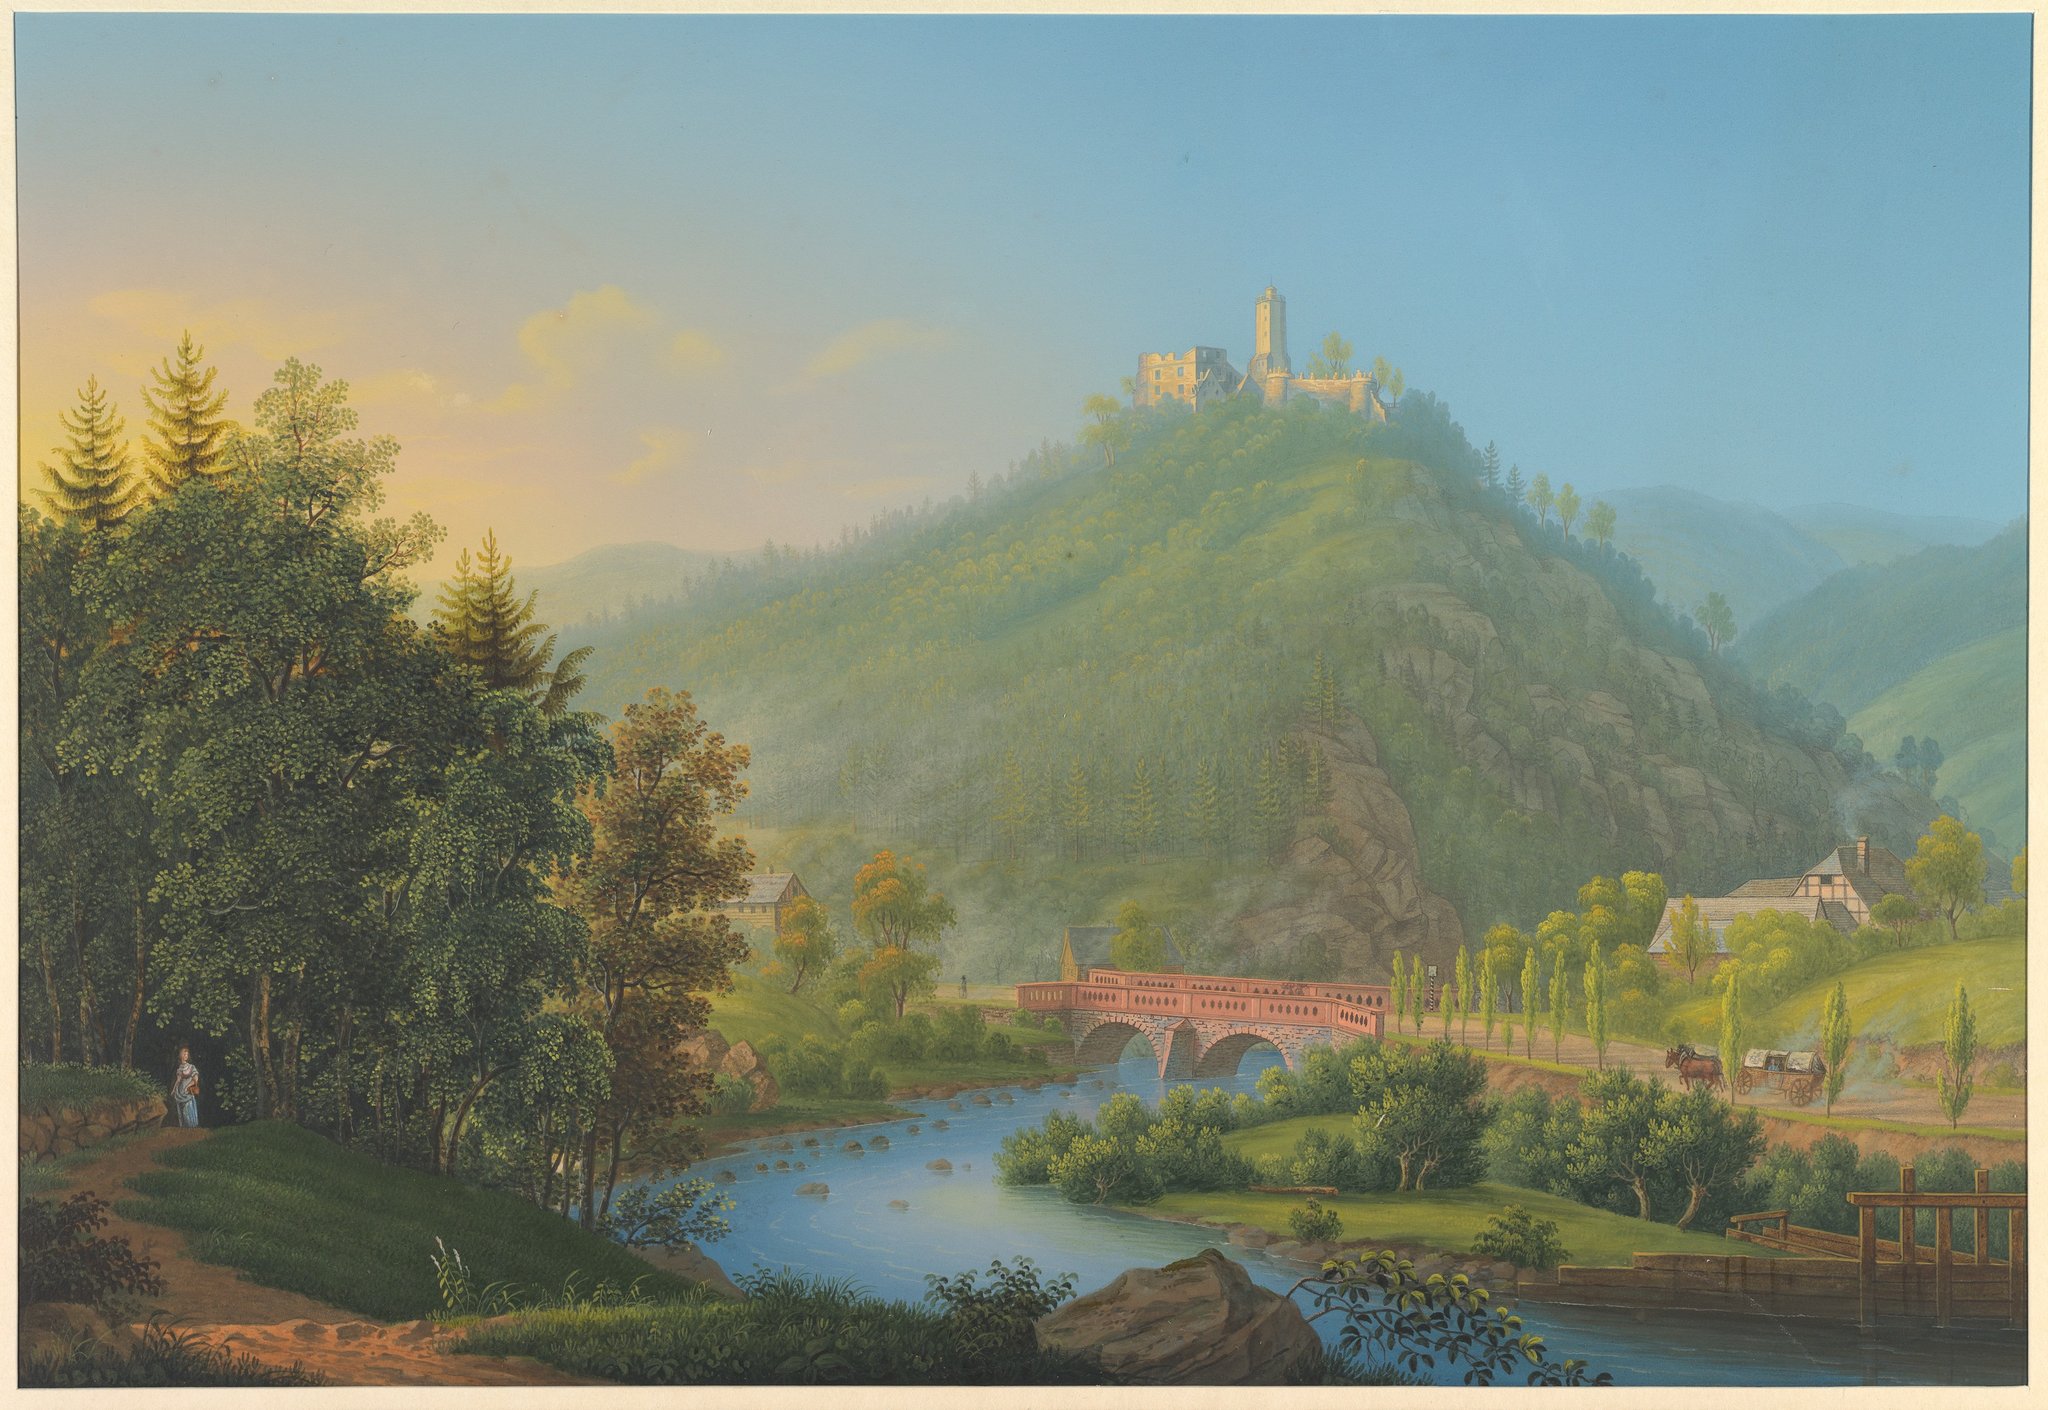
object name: drawing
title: View of Kynsburg over the Weistritz River Valley in Silesia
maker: johann heinrich bleuler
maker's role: artist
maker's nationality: swiss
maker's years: 1758-1823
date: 1767-1900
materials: gouache, graphite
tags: bridges,women,rivers,landscapes,carriages